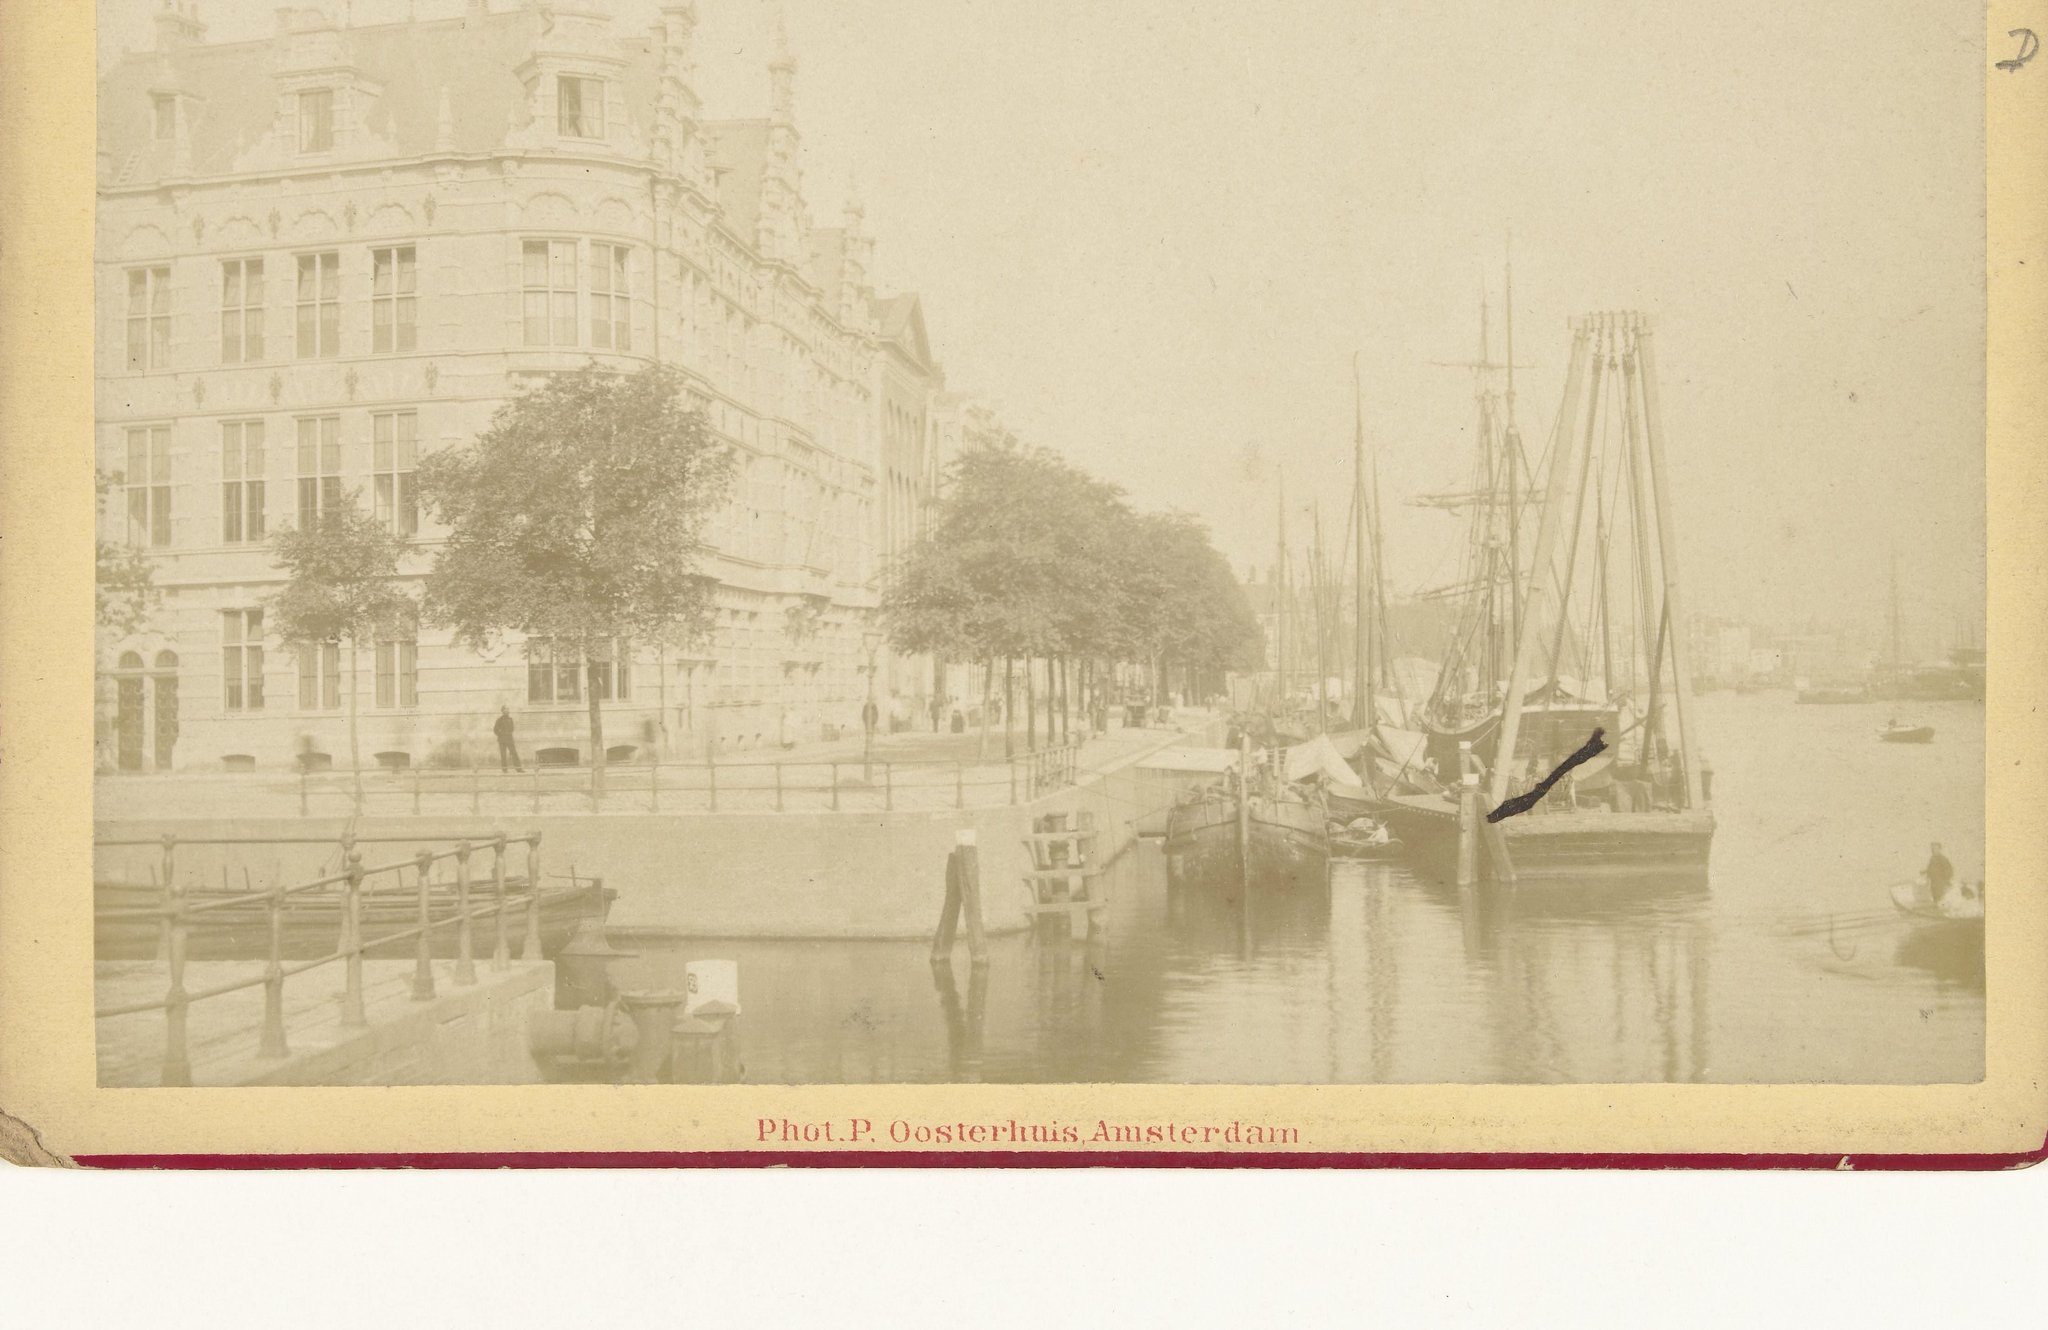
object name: photograph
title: De IJgracht, de tegenwoordige Prins Hendrikkade, gezien in westelijke richting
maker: p. oosterhuis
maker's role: fotograaf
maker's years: 1816-1885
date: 1880-1885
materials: cardboard, paper, photographic support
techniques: albumen print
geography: amsterdam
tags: harbour, ships (in general), canals, waters (in city), amsterdam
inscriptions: name: ‘Phot P. Oosterhuis Amsterdam’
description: De IJgracht, de tegenwoordige Prins Hendrikkade, gezien in westelijke richting. Links de Kweekschool voor de Zeevaart.